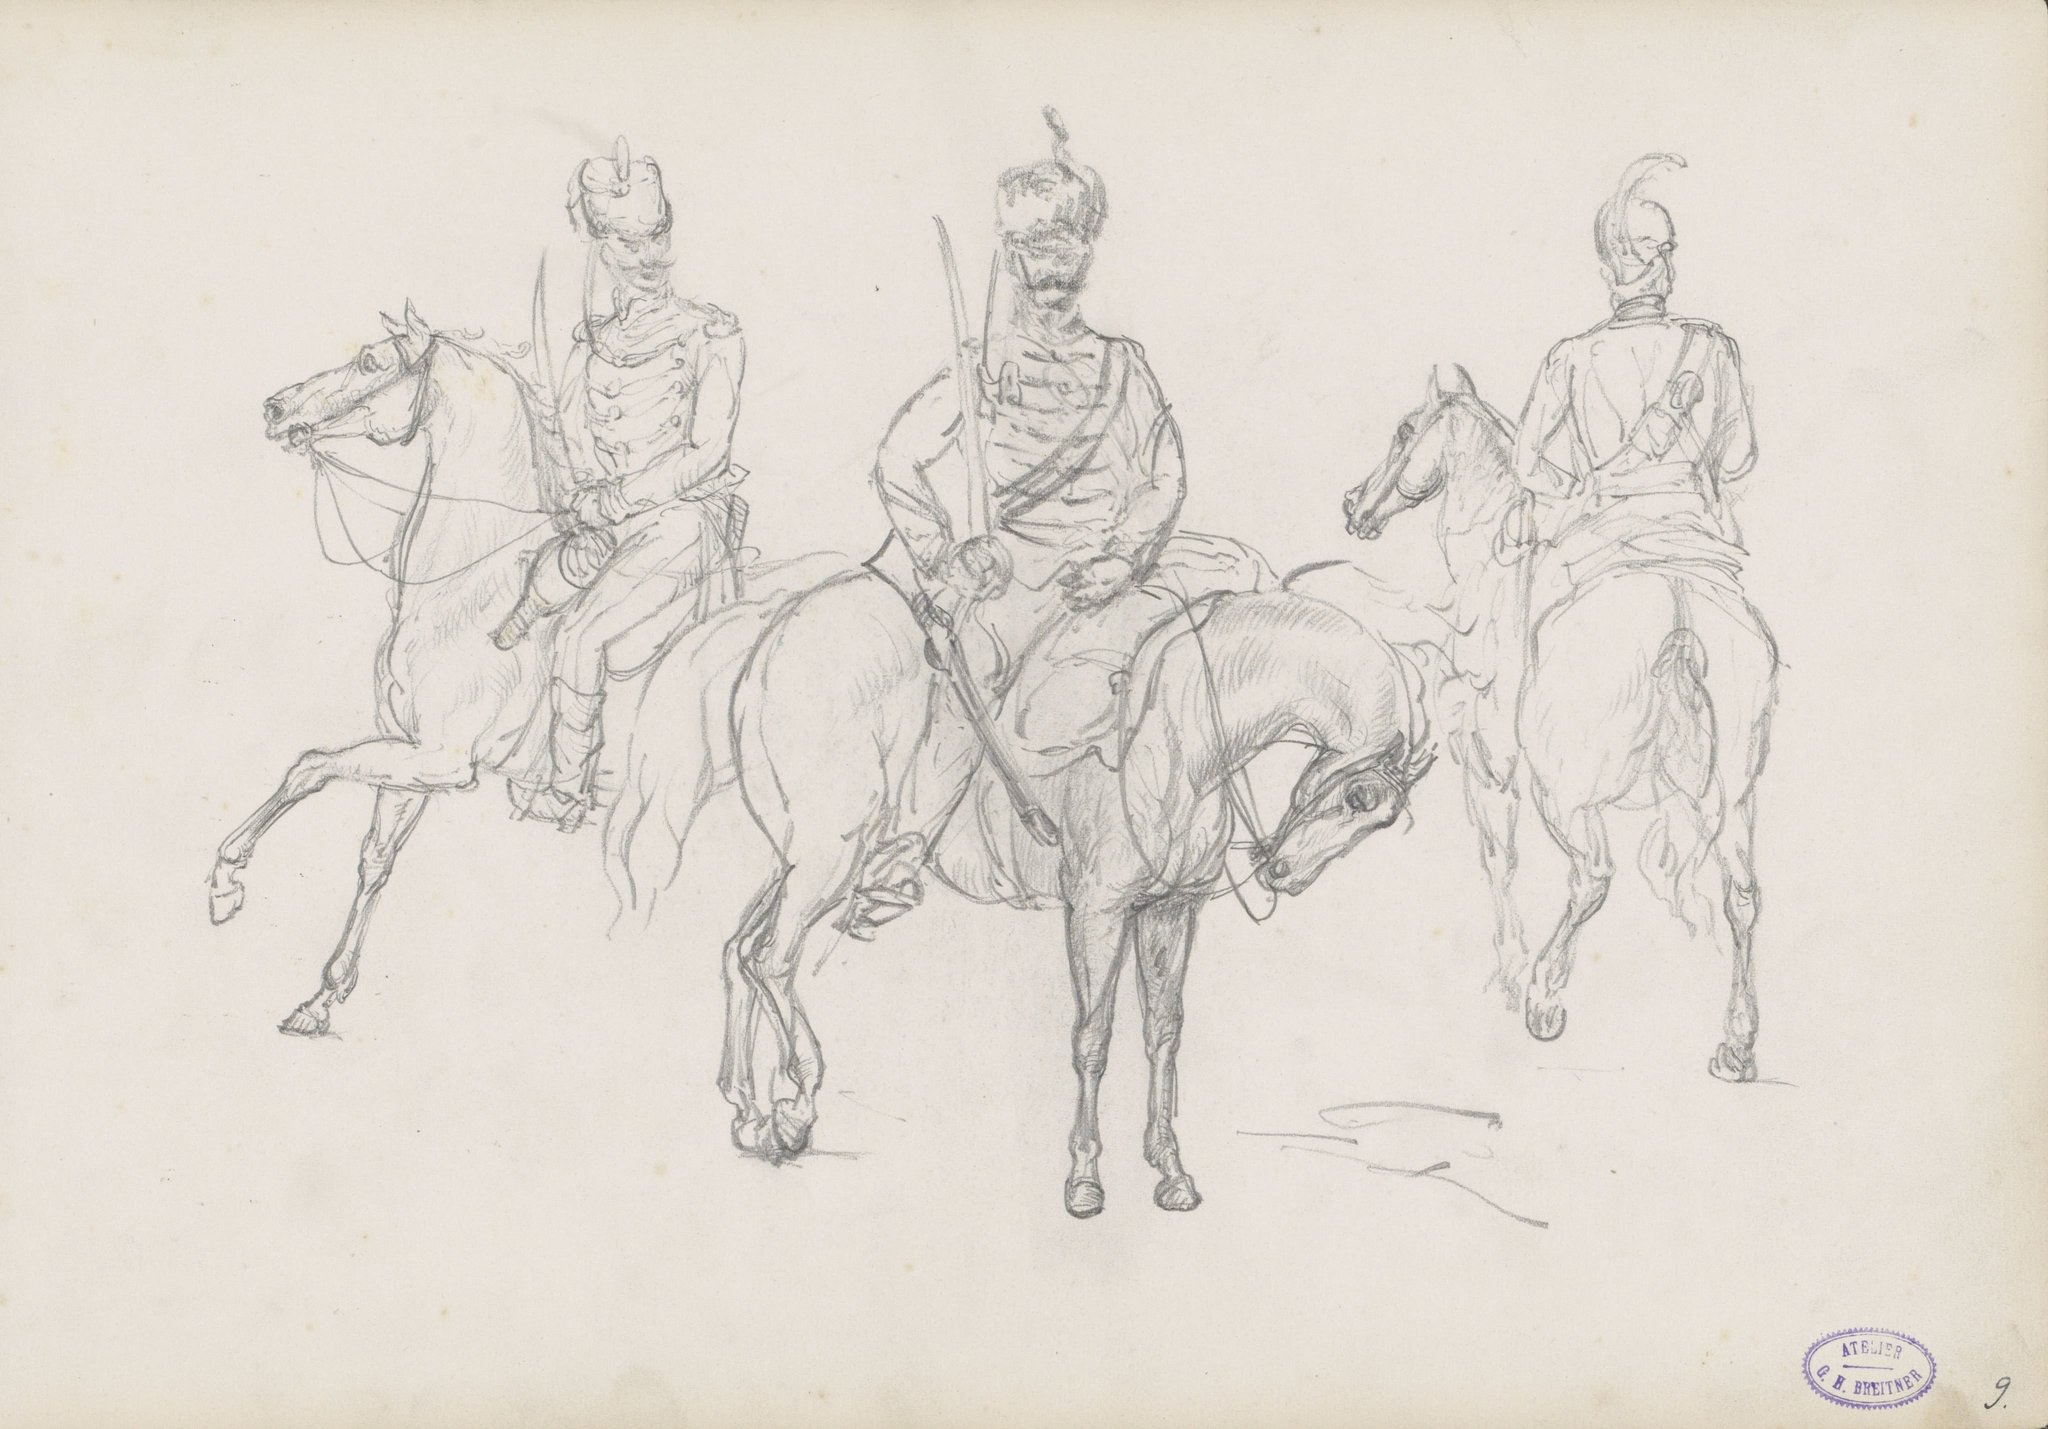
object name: drawing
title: Twee huzaren en een kurassier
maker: george hendrik breitner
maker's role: draughtsman, painter, print maker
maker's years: 1857-1923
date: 1873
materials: paper, pencil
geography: rotterdam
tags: private soldier (+ cavalry, horsemen)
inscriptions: workshop stamp: Lugt 291d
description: Deze tekening heeft oorspronkelijk als blad 9 deel uitgemaakt van een schetsboek. Zie voor dit schetsboek het gerelateerd object.